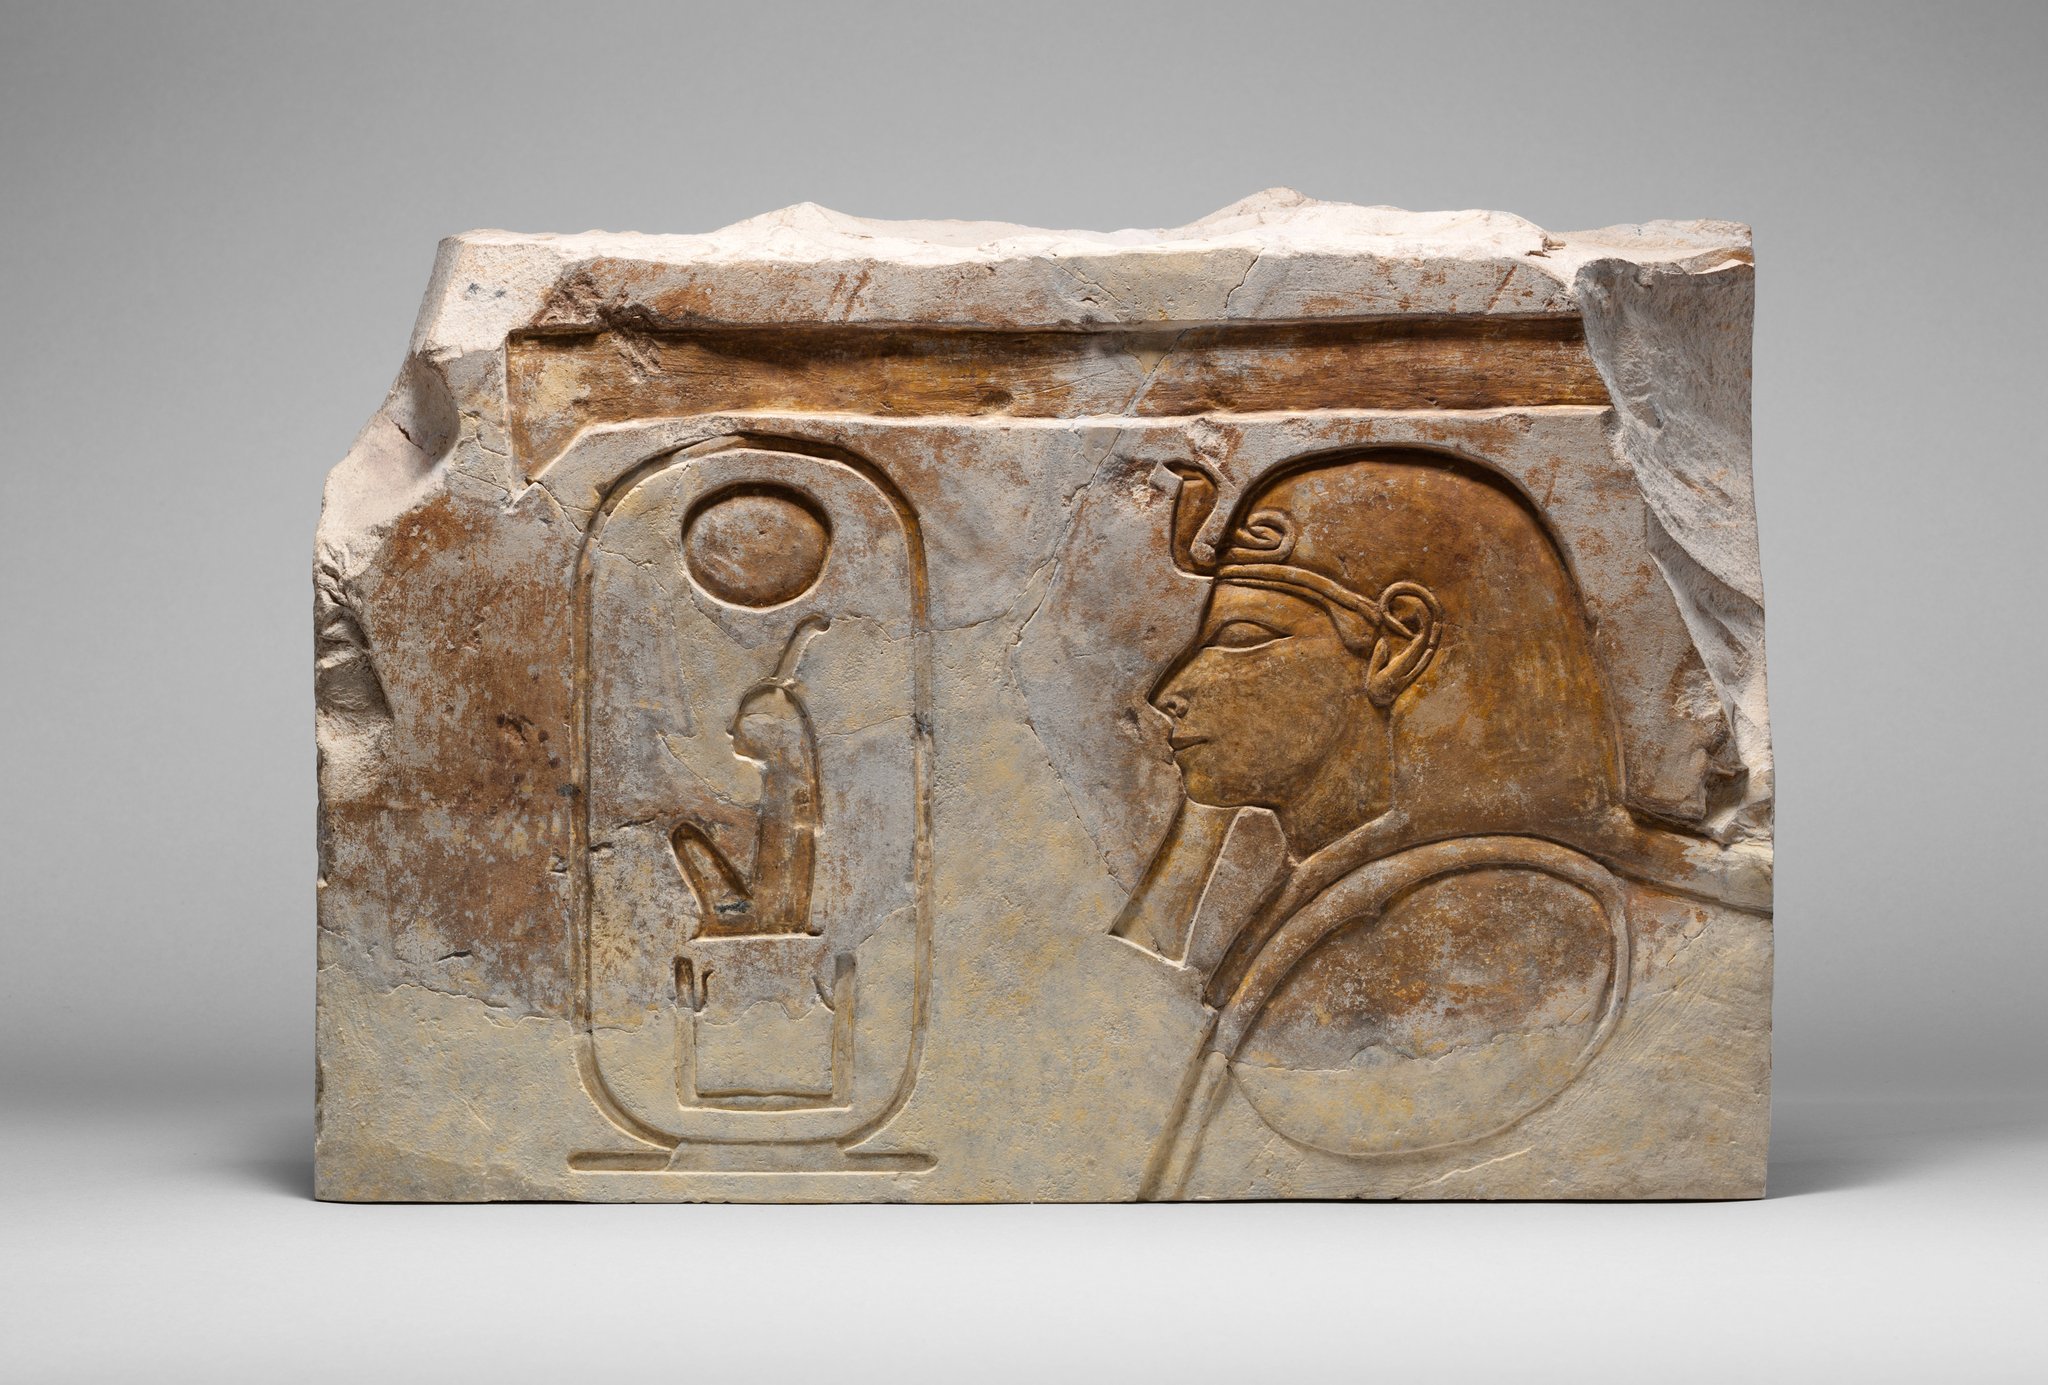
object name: statue base, hatshepsut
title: Hatshepsut statue base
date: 1479-1458 BCE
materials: limestone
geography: egypt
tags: hieroglyphs